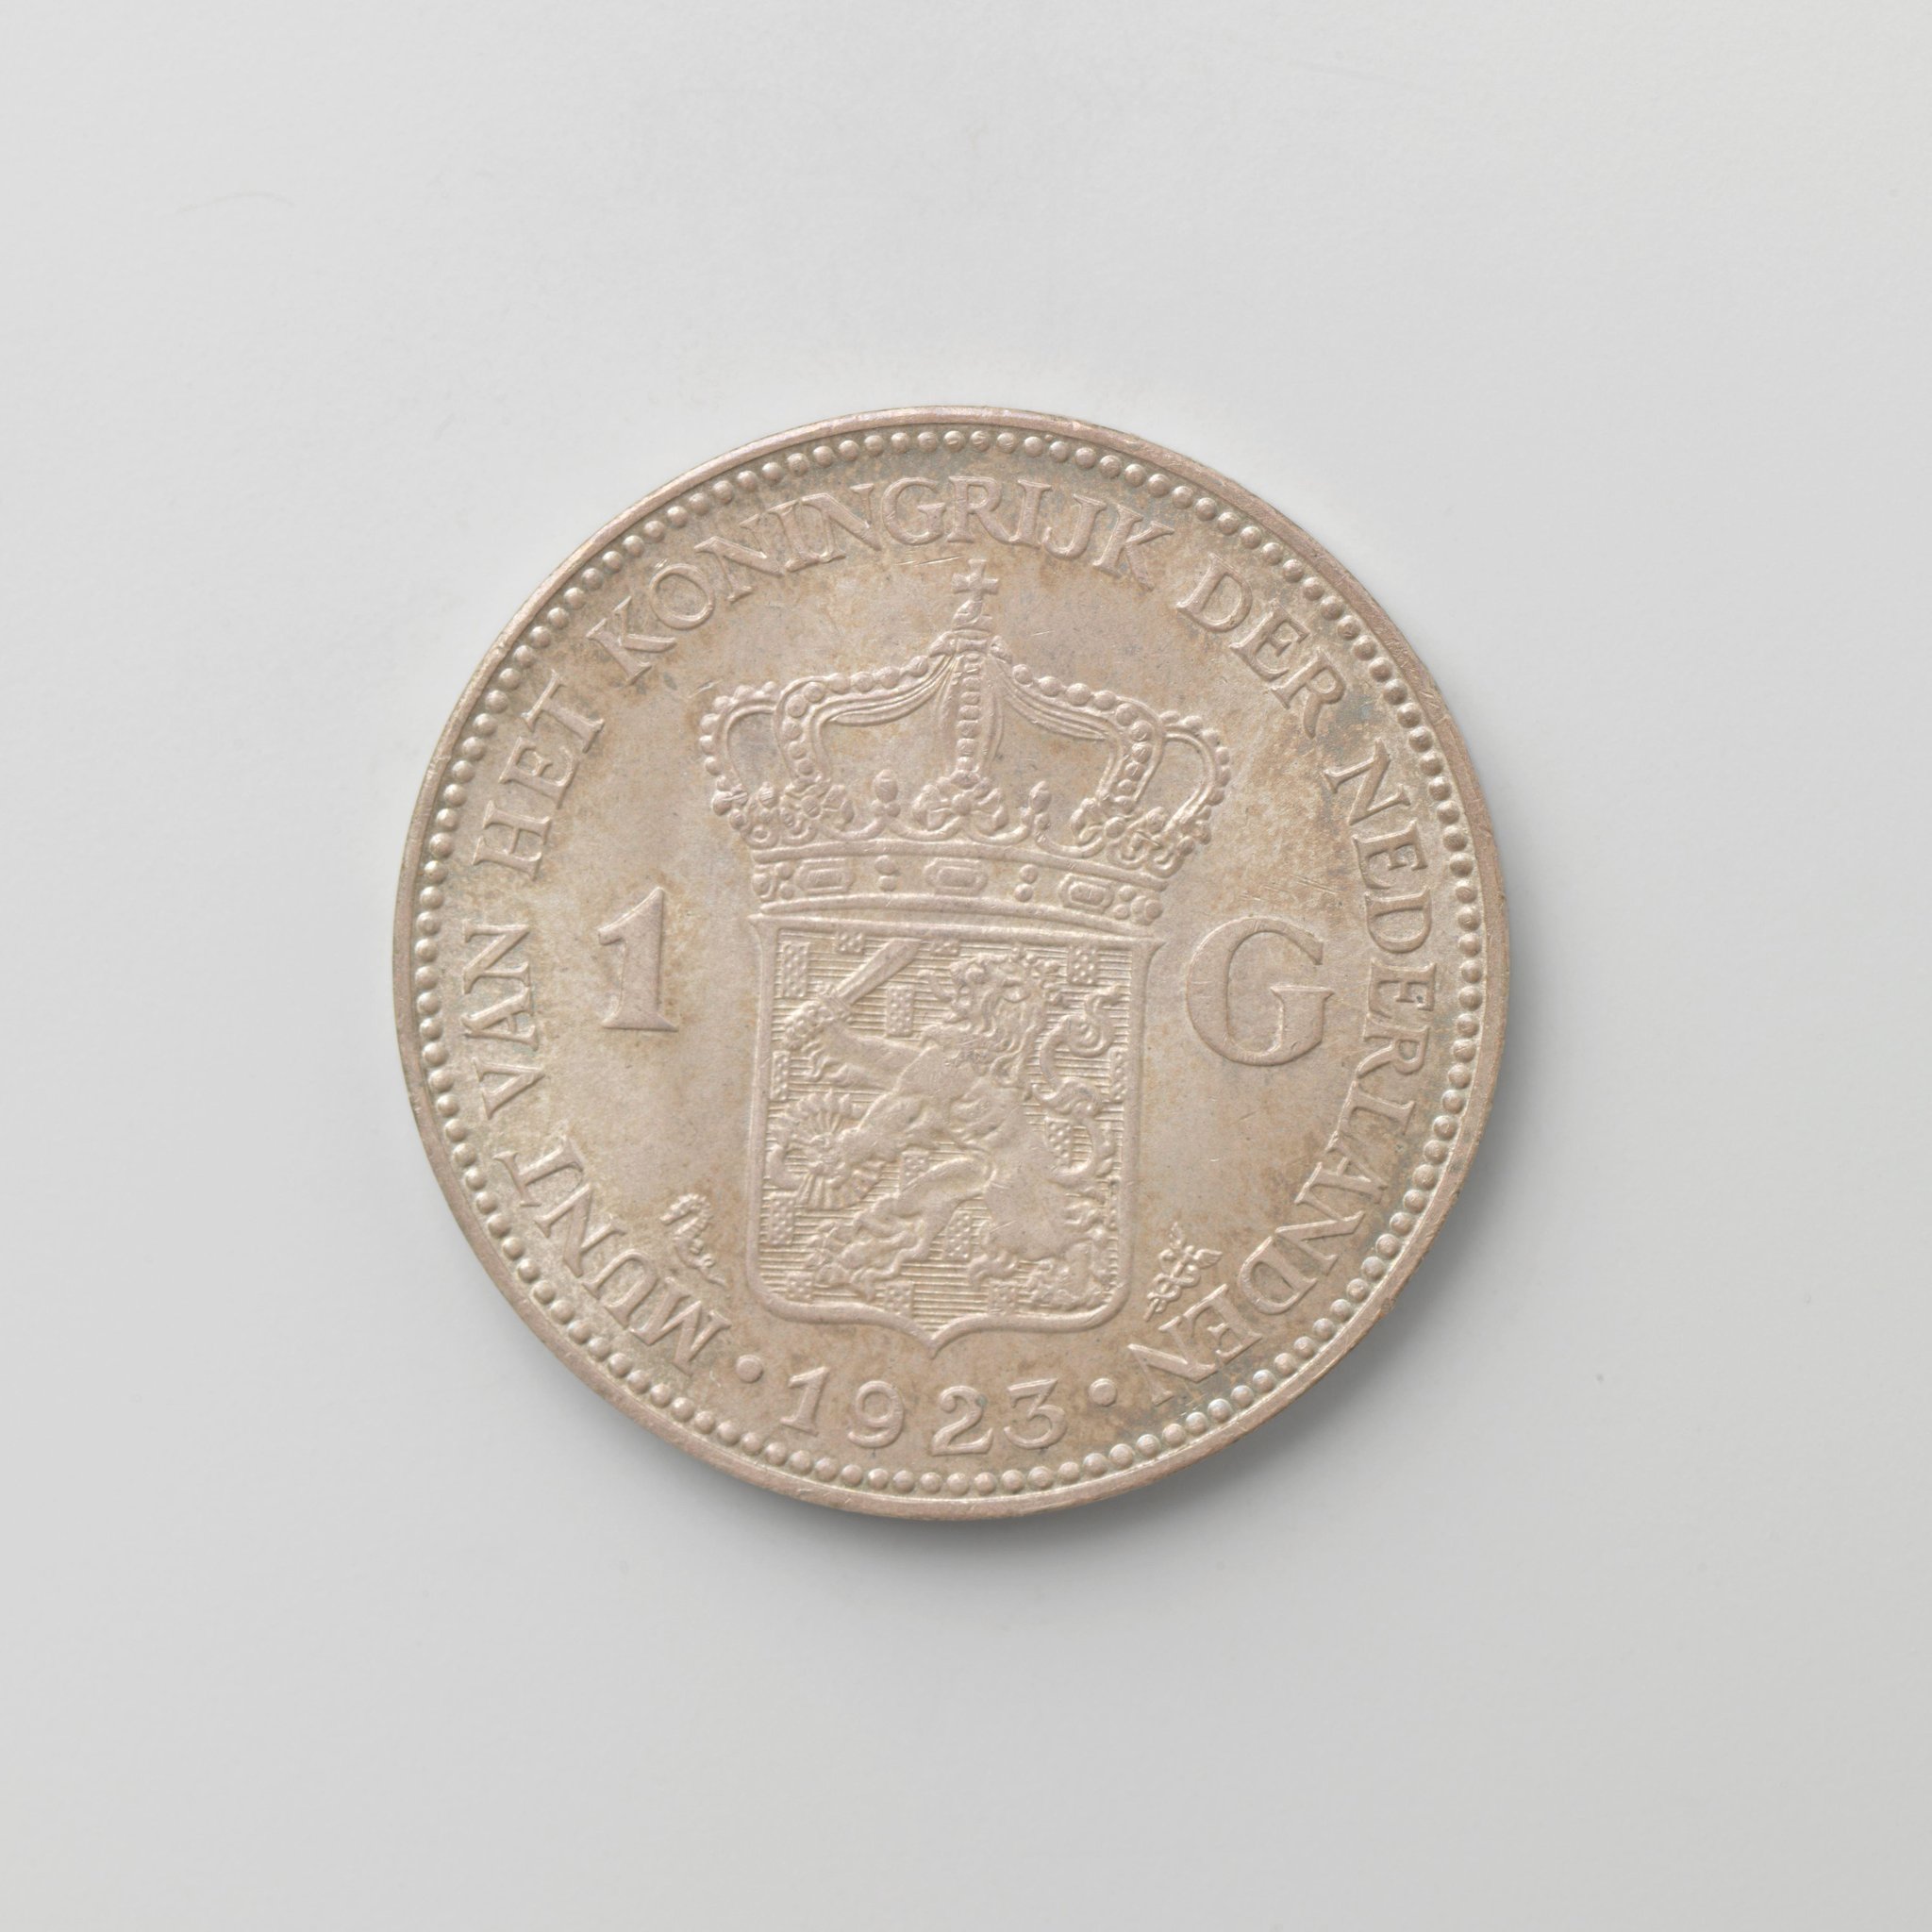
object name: coin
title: Nederlandse gulden,1923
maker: wilhelmina of the netherlands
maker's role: print maker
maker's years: 1880-1962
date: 1923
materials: silver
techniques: striking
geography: utrecht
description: Zilveren munt. Voorzijde: hoofd naar links. Keerzijde: tussen waarde-aanduiding 1 G gekroond rijkswapenschild. Jaartal onderaan in omschrift. Randschrift.